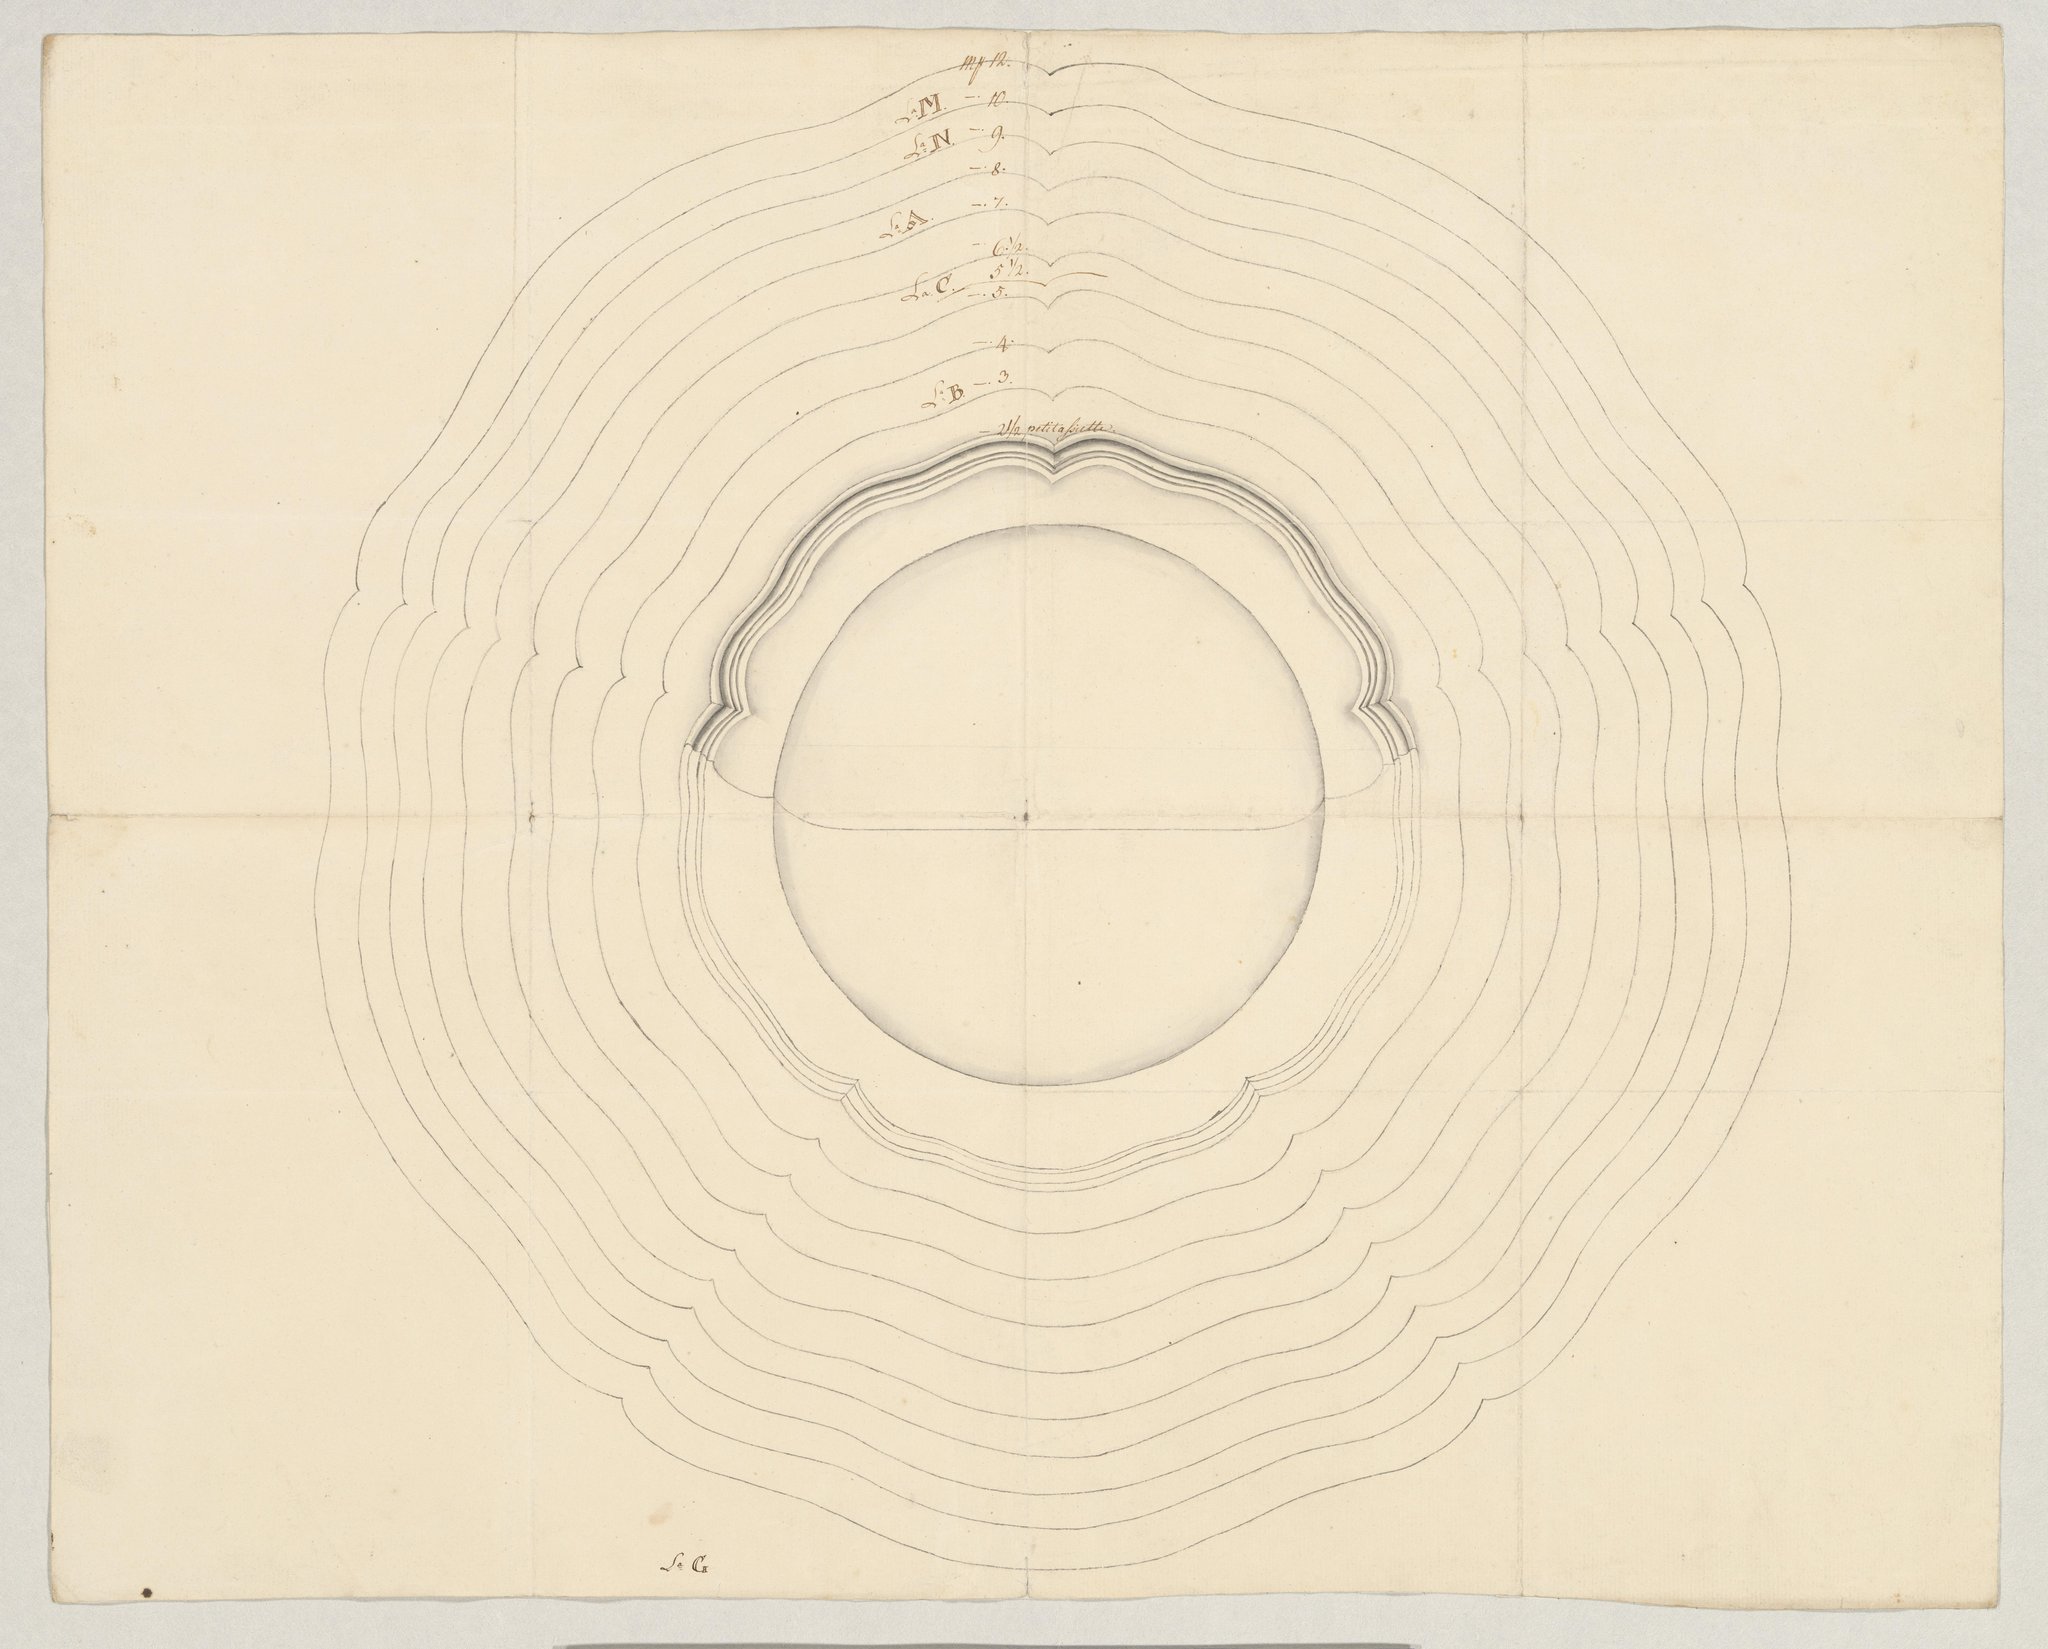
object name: design drawing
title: Ontwerp voor een reeks borden in veschillende groottes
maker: Anonymous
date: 1750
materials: ink, paper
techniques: brush, pen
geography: germany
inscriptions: watermark, annotation: ‘La. G / M// 12. / La. M. _. 10. / La. N. _. 9. / _. 8 / La. A. _. 7. / _. 6 1/2. / La. C. _. 5 1/2. / _. 5. / _. 4. / La. B. _. 3. / _ 2 1/2 petit assiette’